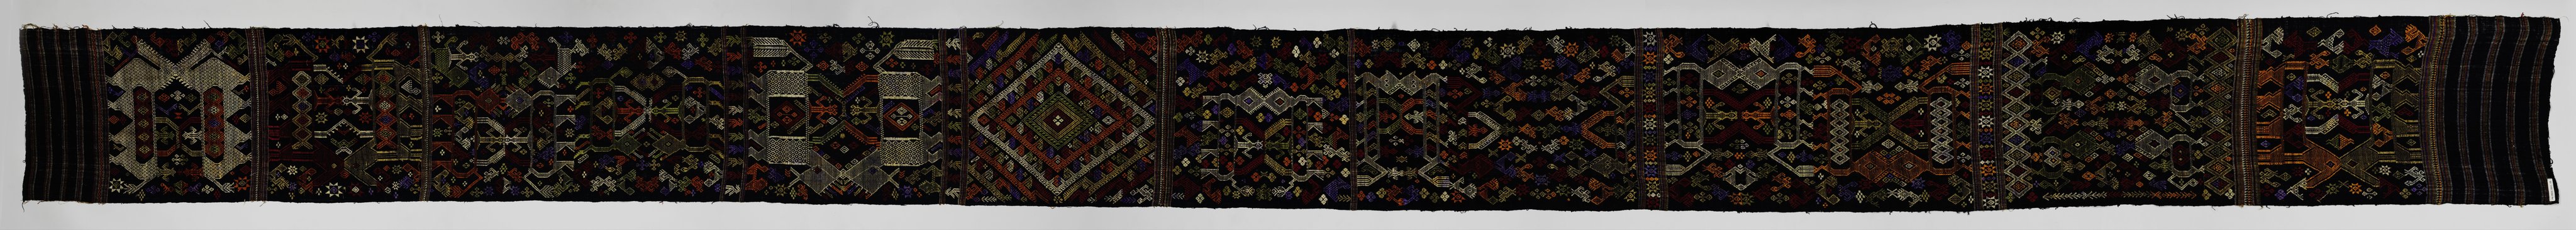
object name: cloth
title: Tung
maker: Anonymous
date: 1900-1949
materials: cotton, silk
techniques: weave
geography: laos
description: Doek met dierfiguren en geometrische motieven.